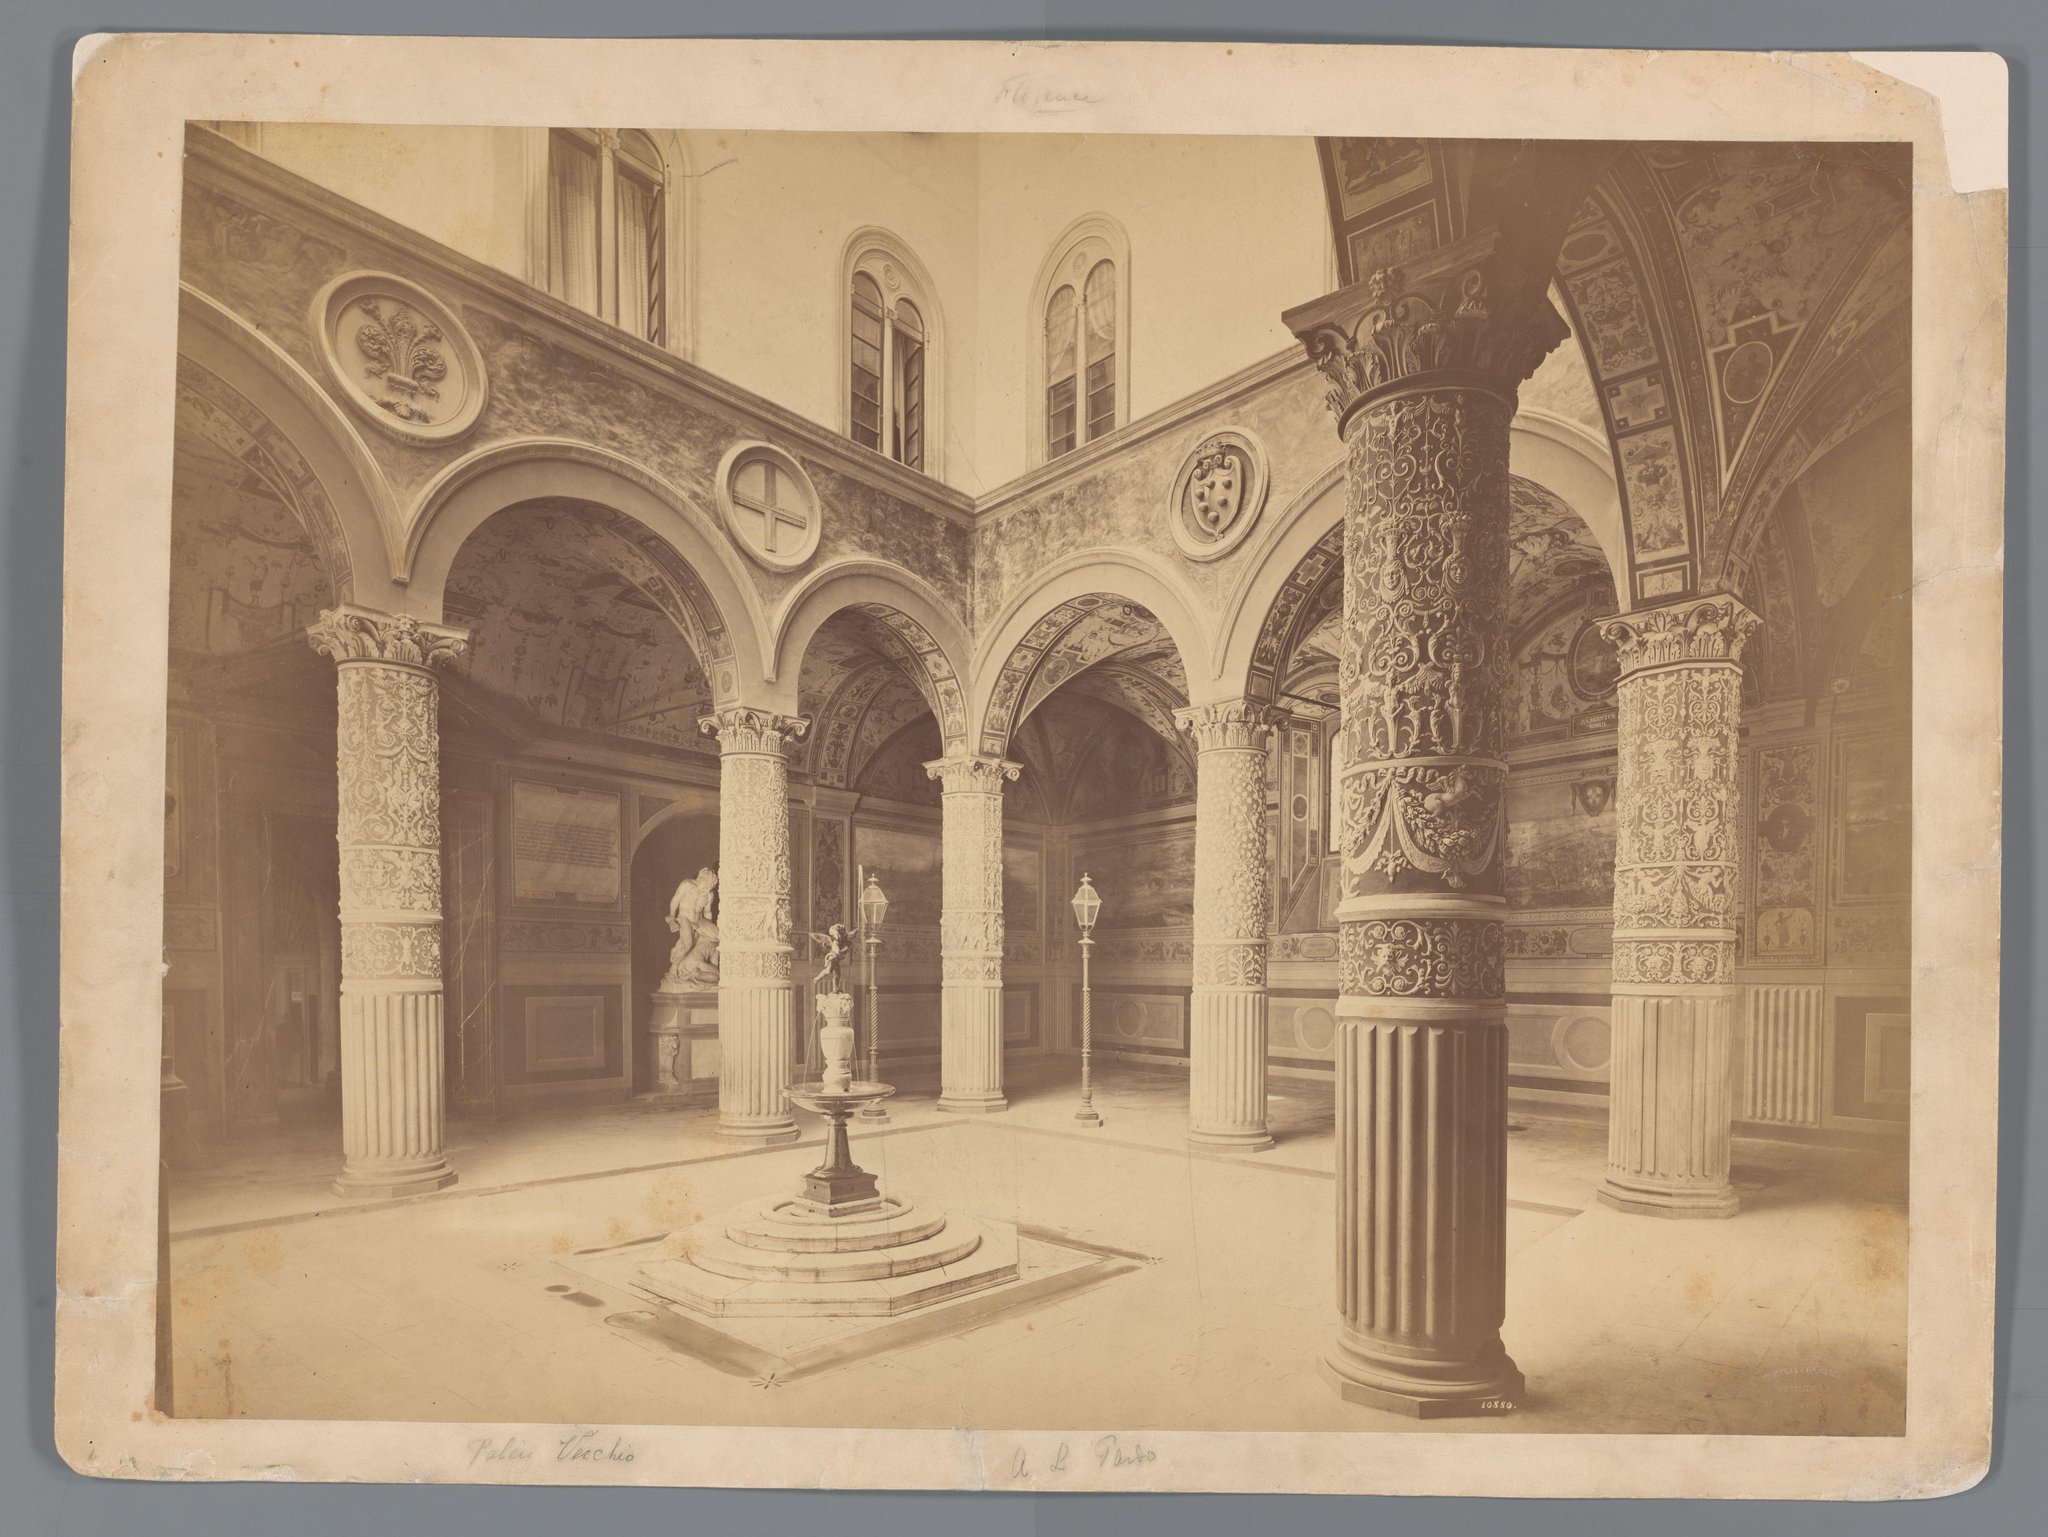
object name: photograph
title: Binnenplaats van het Palazzo Vecchio te Florence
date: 1880-1900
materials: cardboard, paper, photographic support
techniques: albumen print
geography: florence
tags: palazzo vecchio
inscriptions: : ‘FRATELLI ALINARI / FIRENZE’, : ‘10880.’, stamp: ‘RYKS.SCHOOL.VOOR.KUNSTNYVERHEID / GROEP’